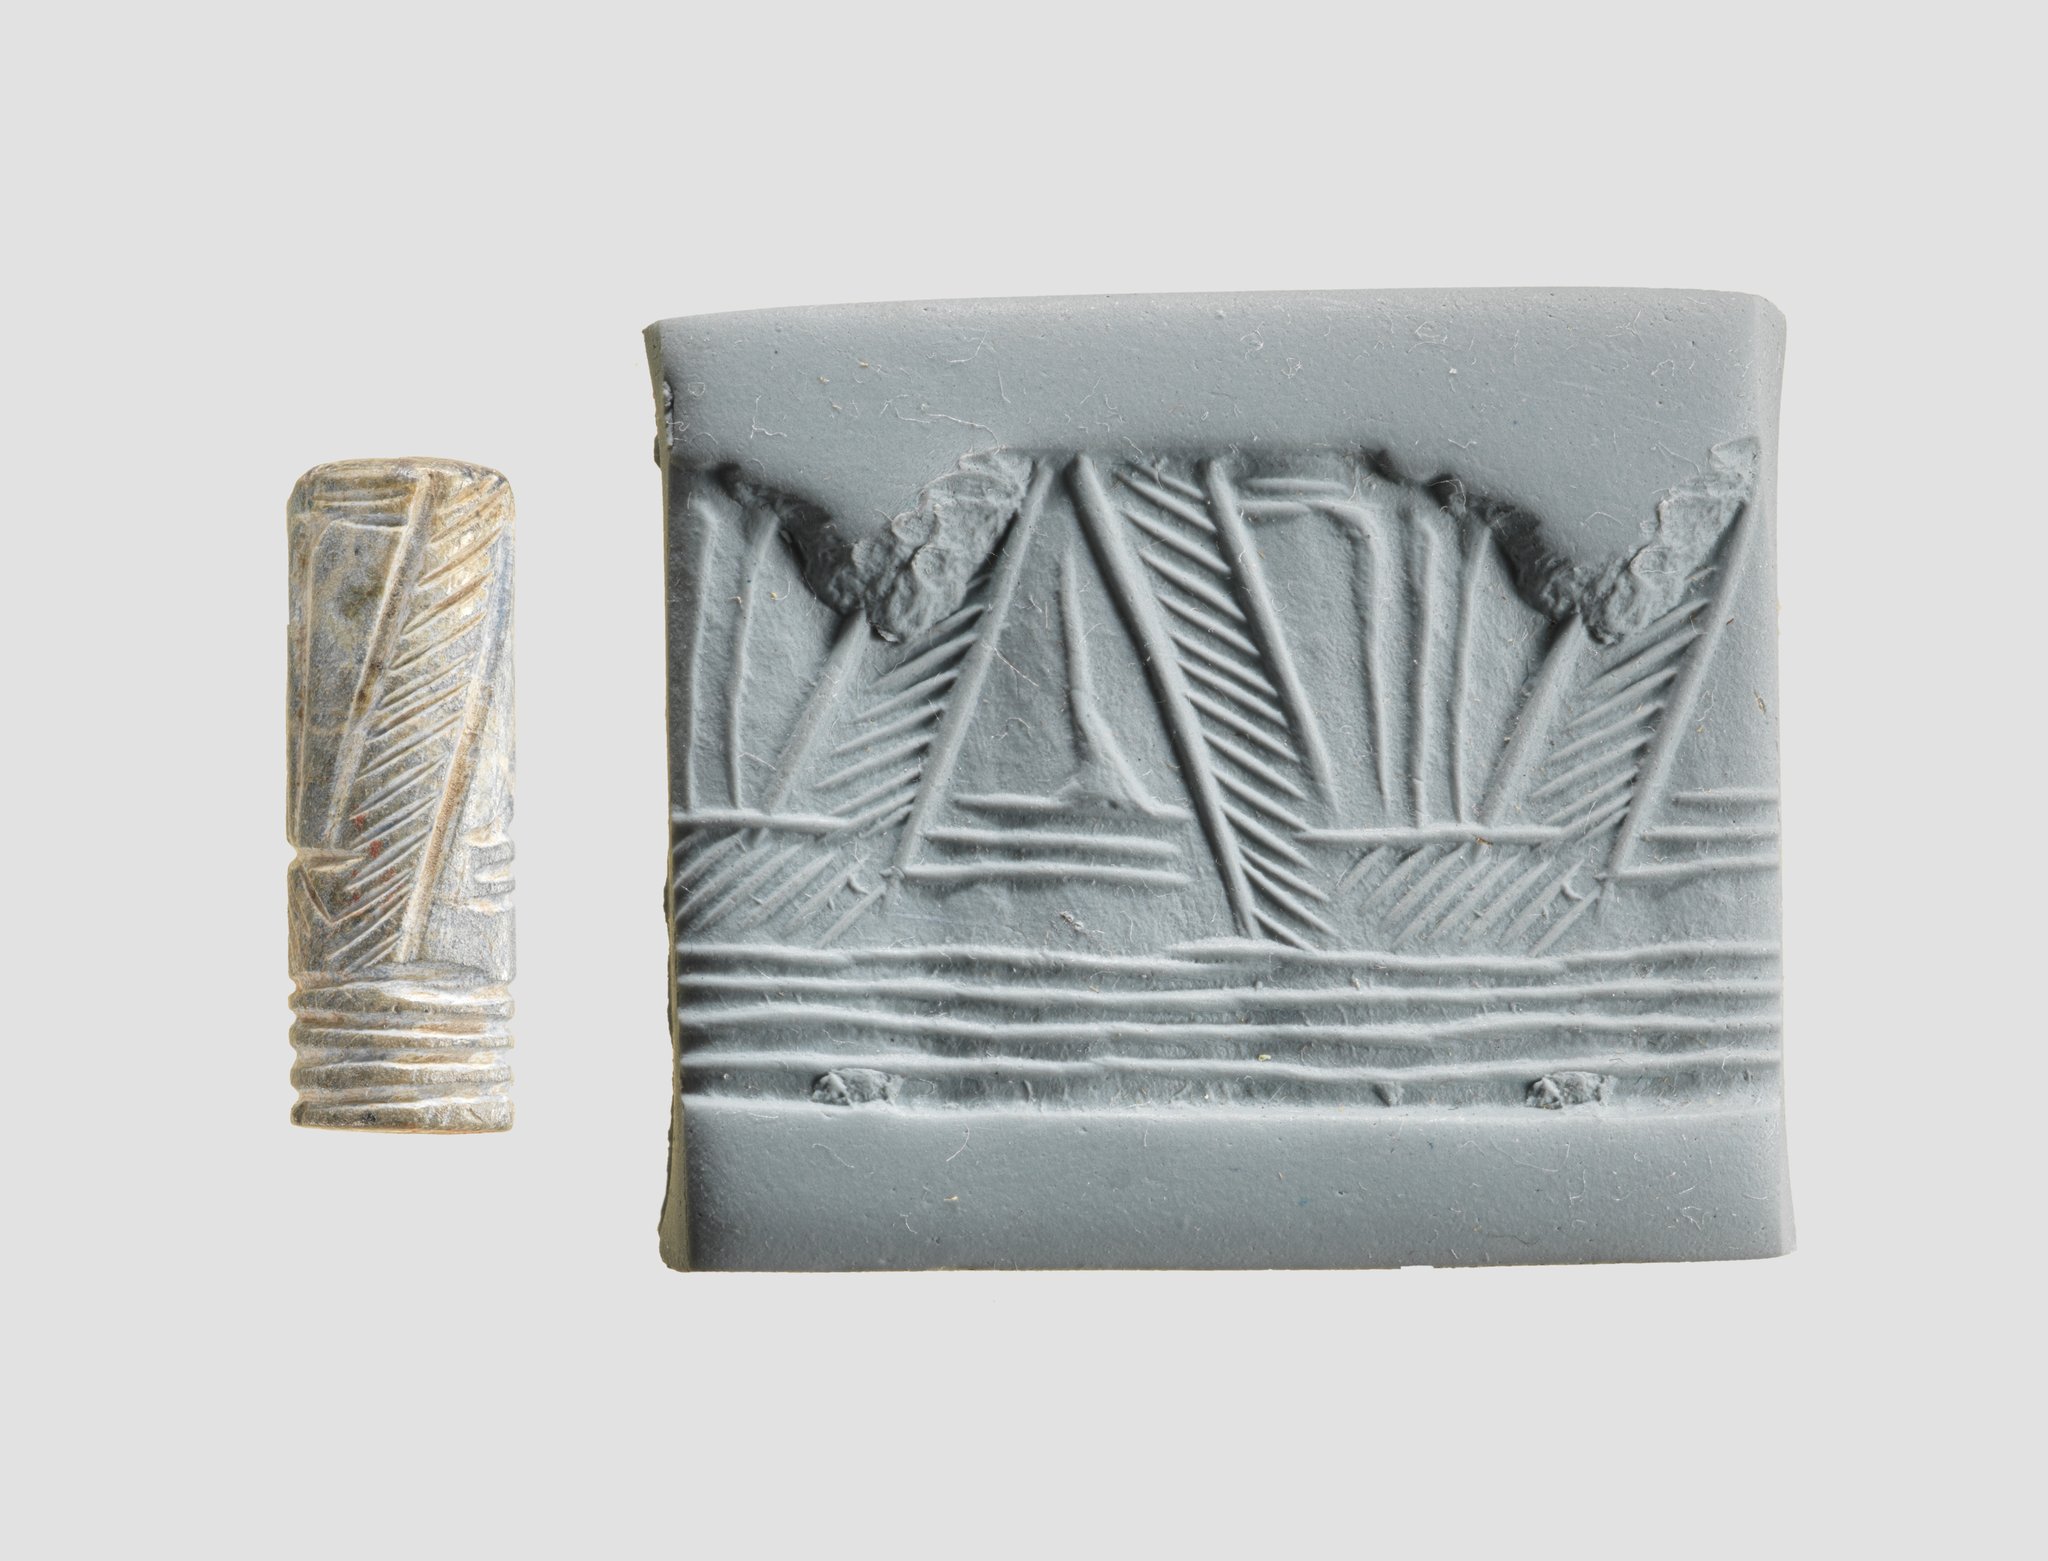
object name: cylinder seal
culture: iranian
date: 3100-2900 BCE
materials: faience